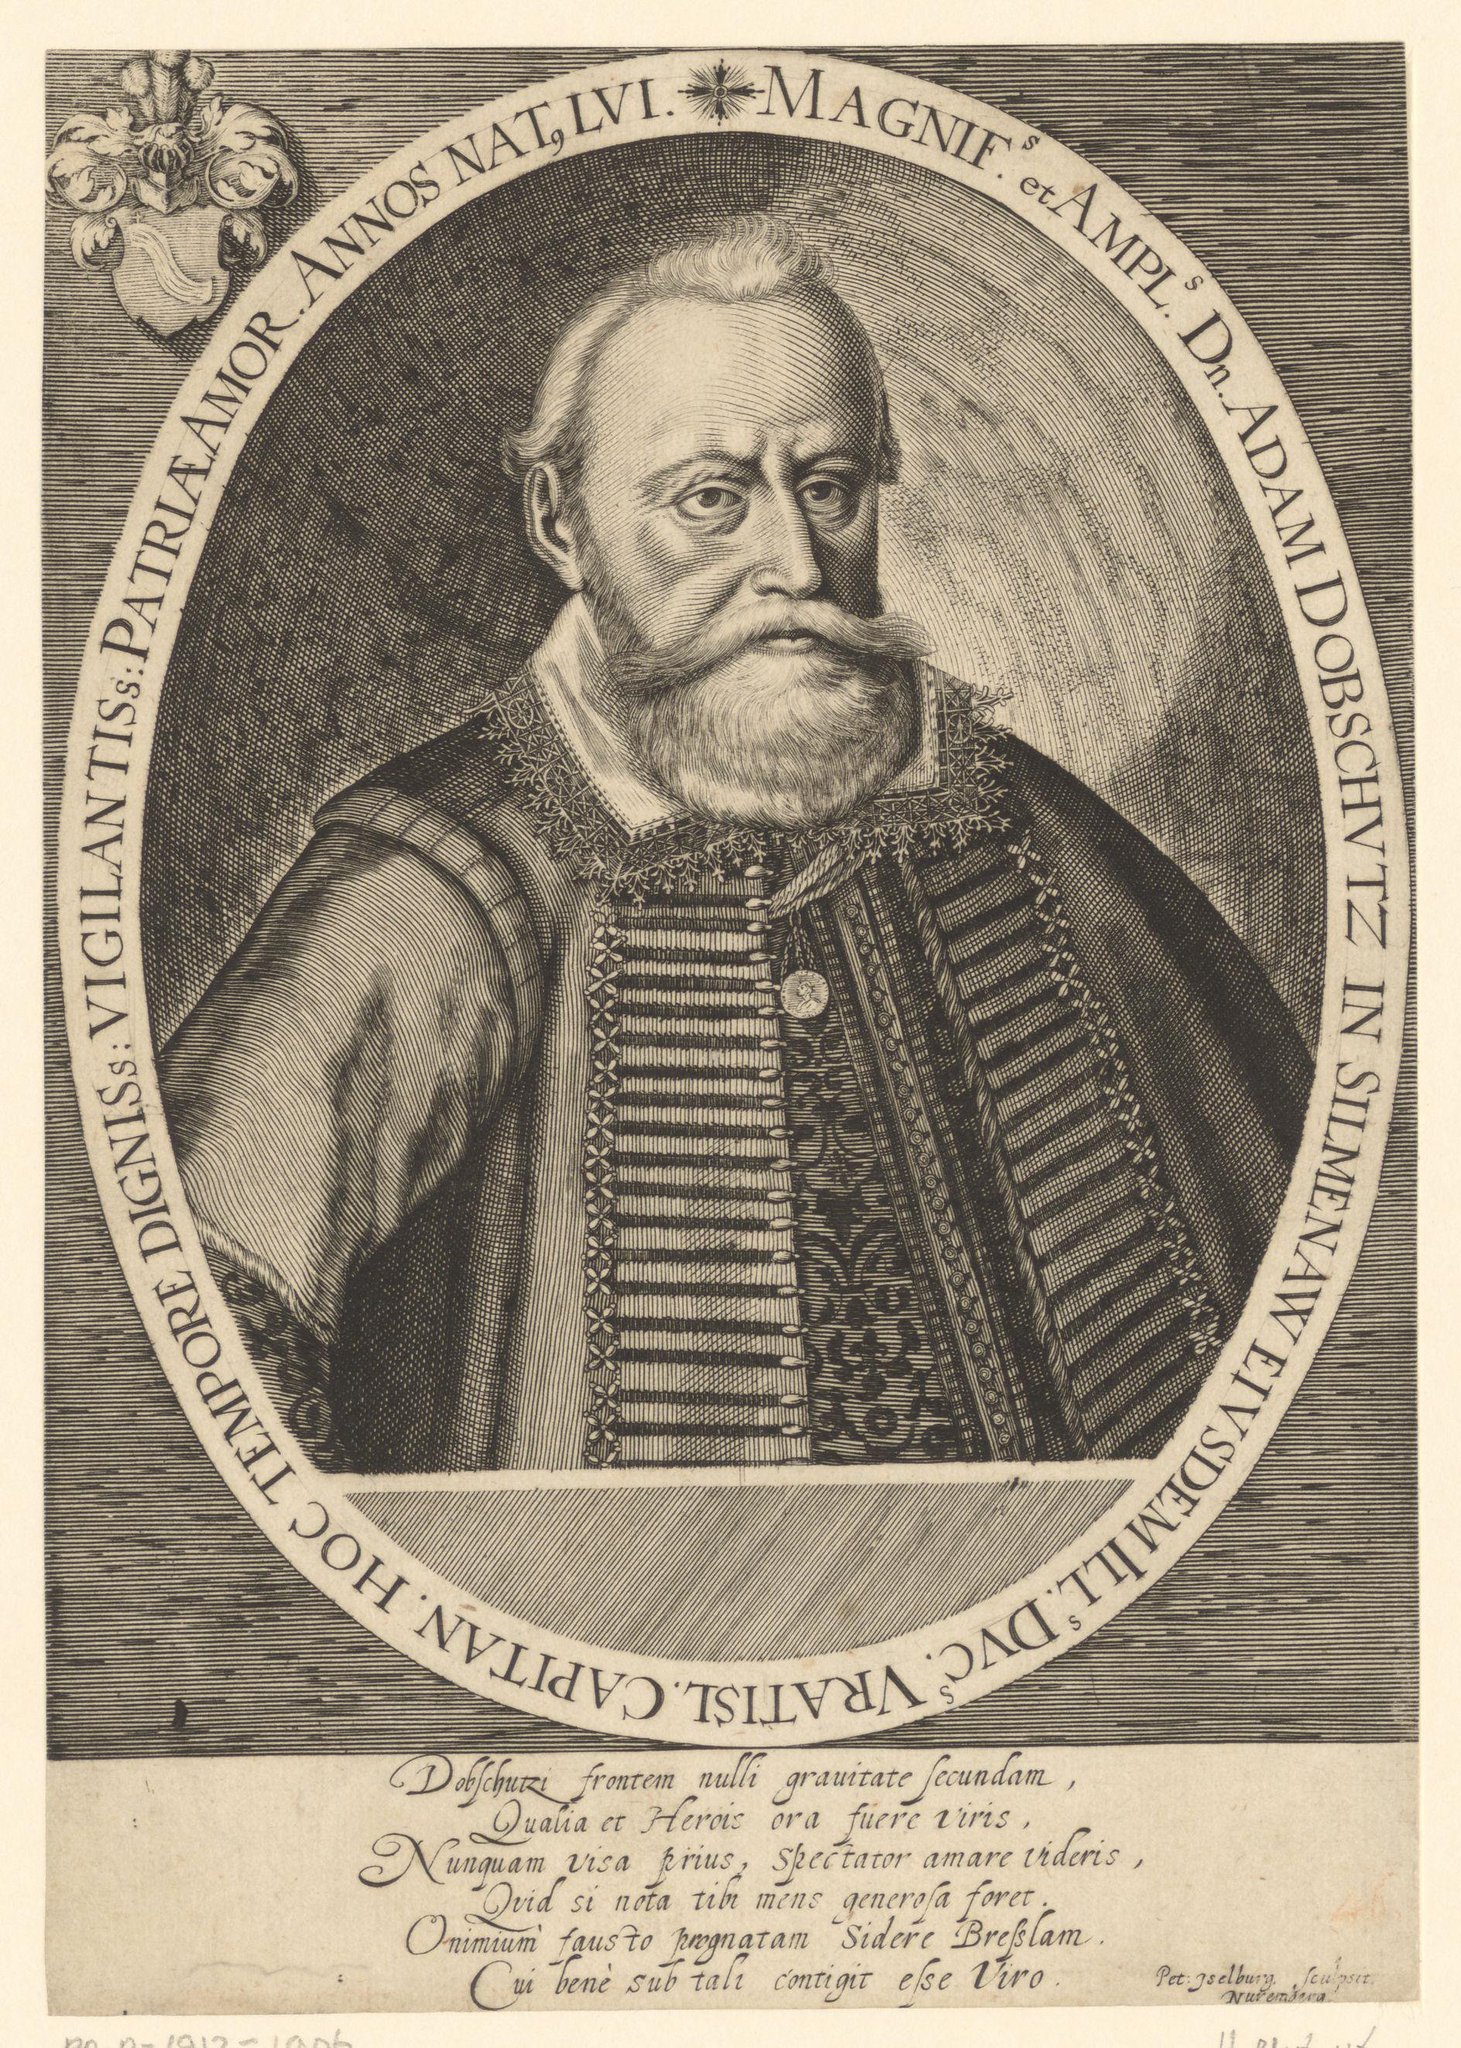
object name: print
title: Portret van Adam Dobschütz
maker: peter isselburg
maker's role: print maker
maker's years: 1568-1630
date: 1578-1678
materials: paper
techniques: engraving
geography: nuremberg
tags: politician, theologian, historical persons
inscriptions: collector's mark: Lugt 2228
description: Tekst in het Latijn in de omlijsting en in de marge.